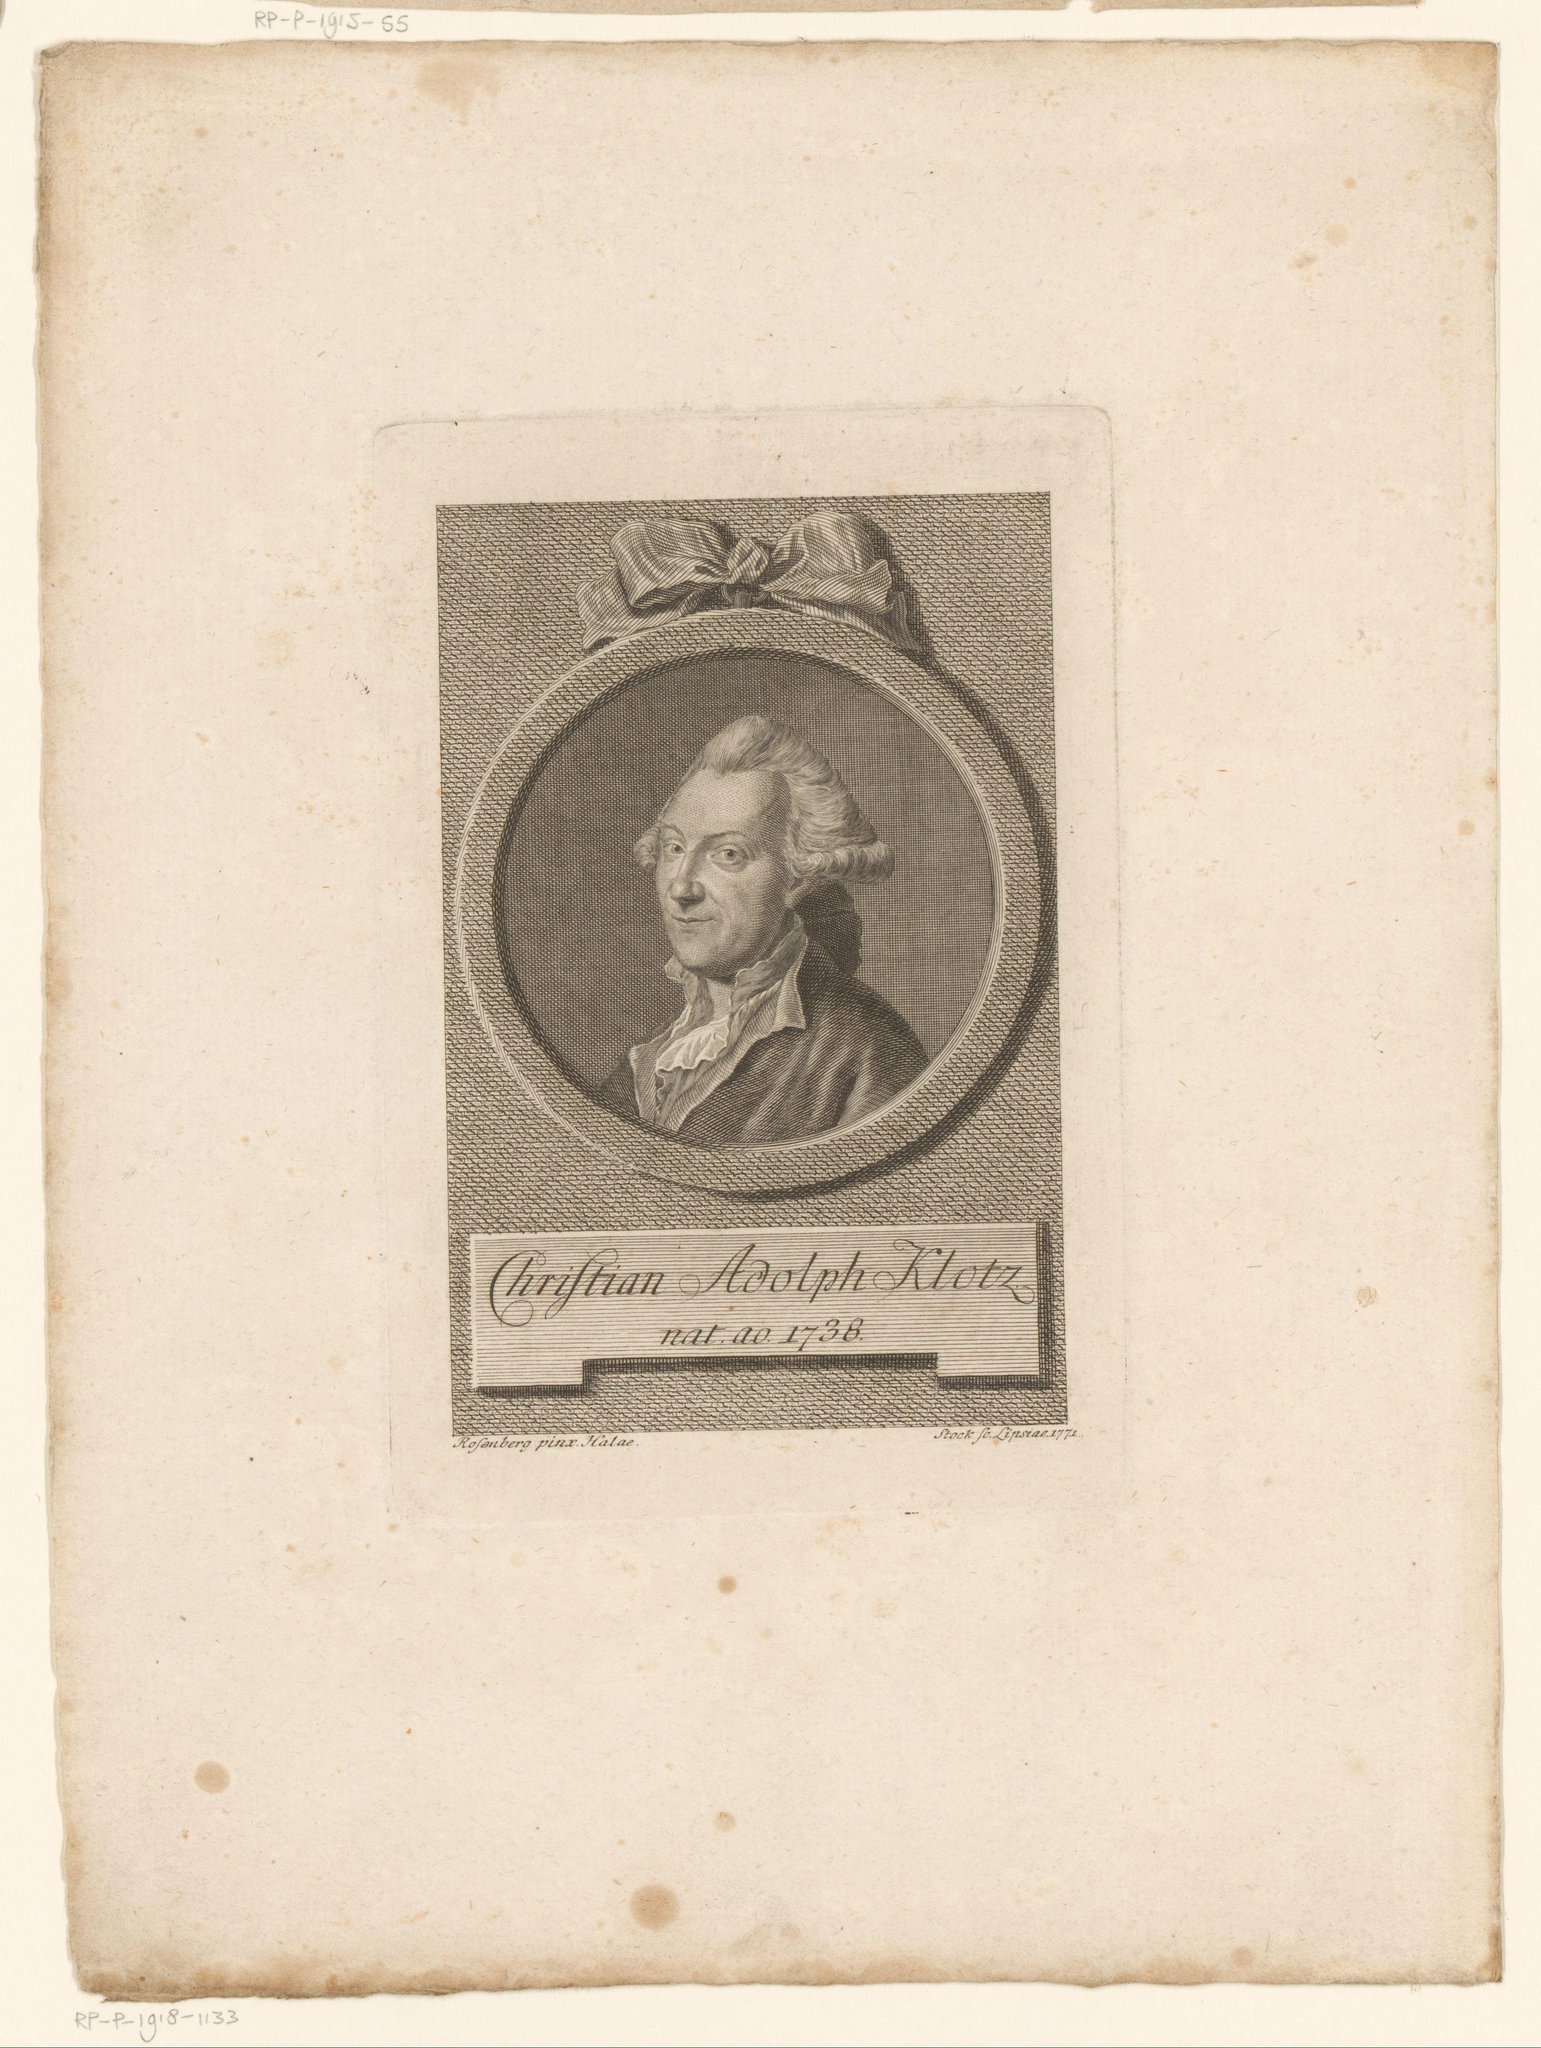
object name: print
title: Portret van Christian Adolph Klotz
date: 1771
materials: paper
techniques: engraving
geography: halle an der saale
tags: historical persons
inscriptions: collector's mark: Lugt 2228